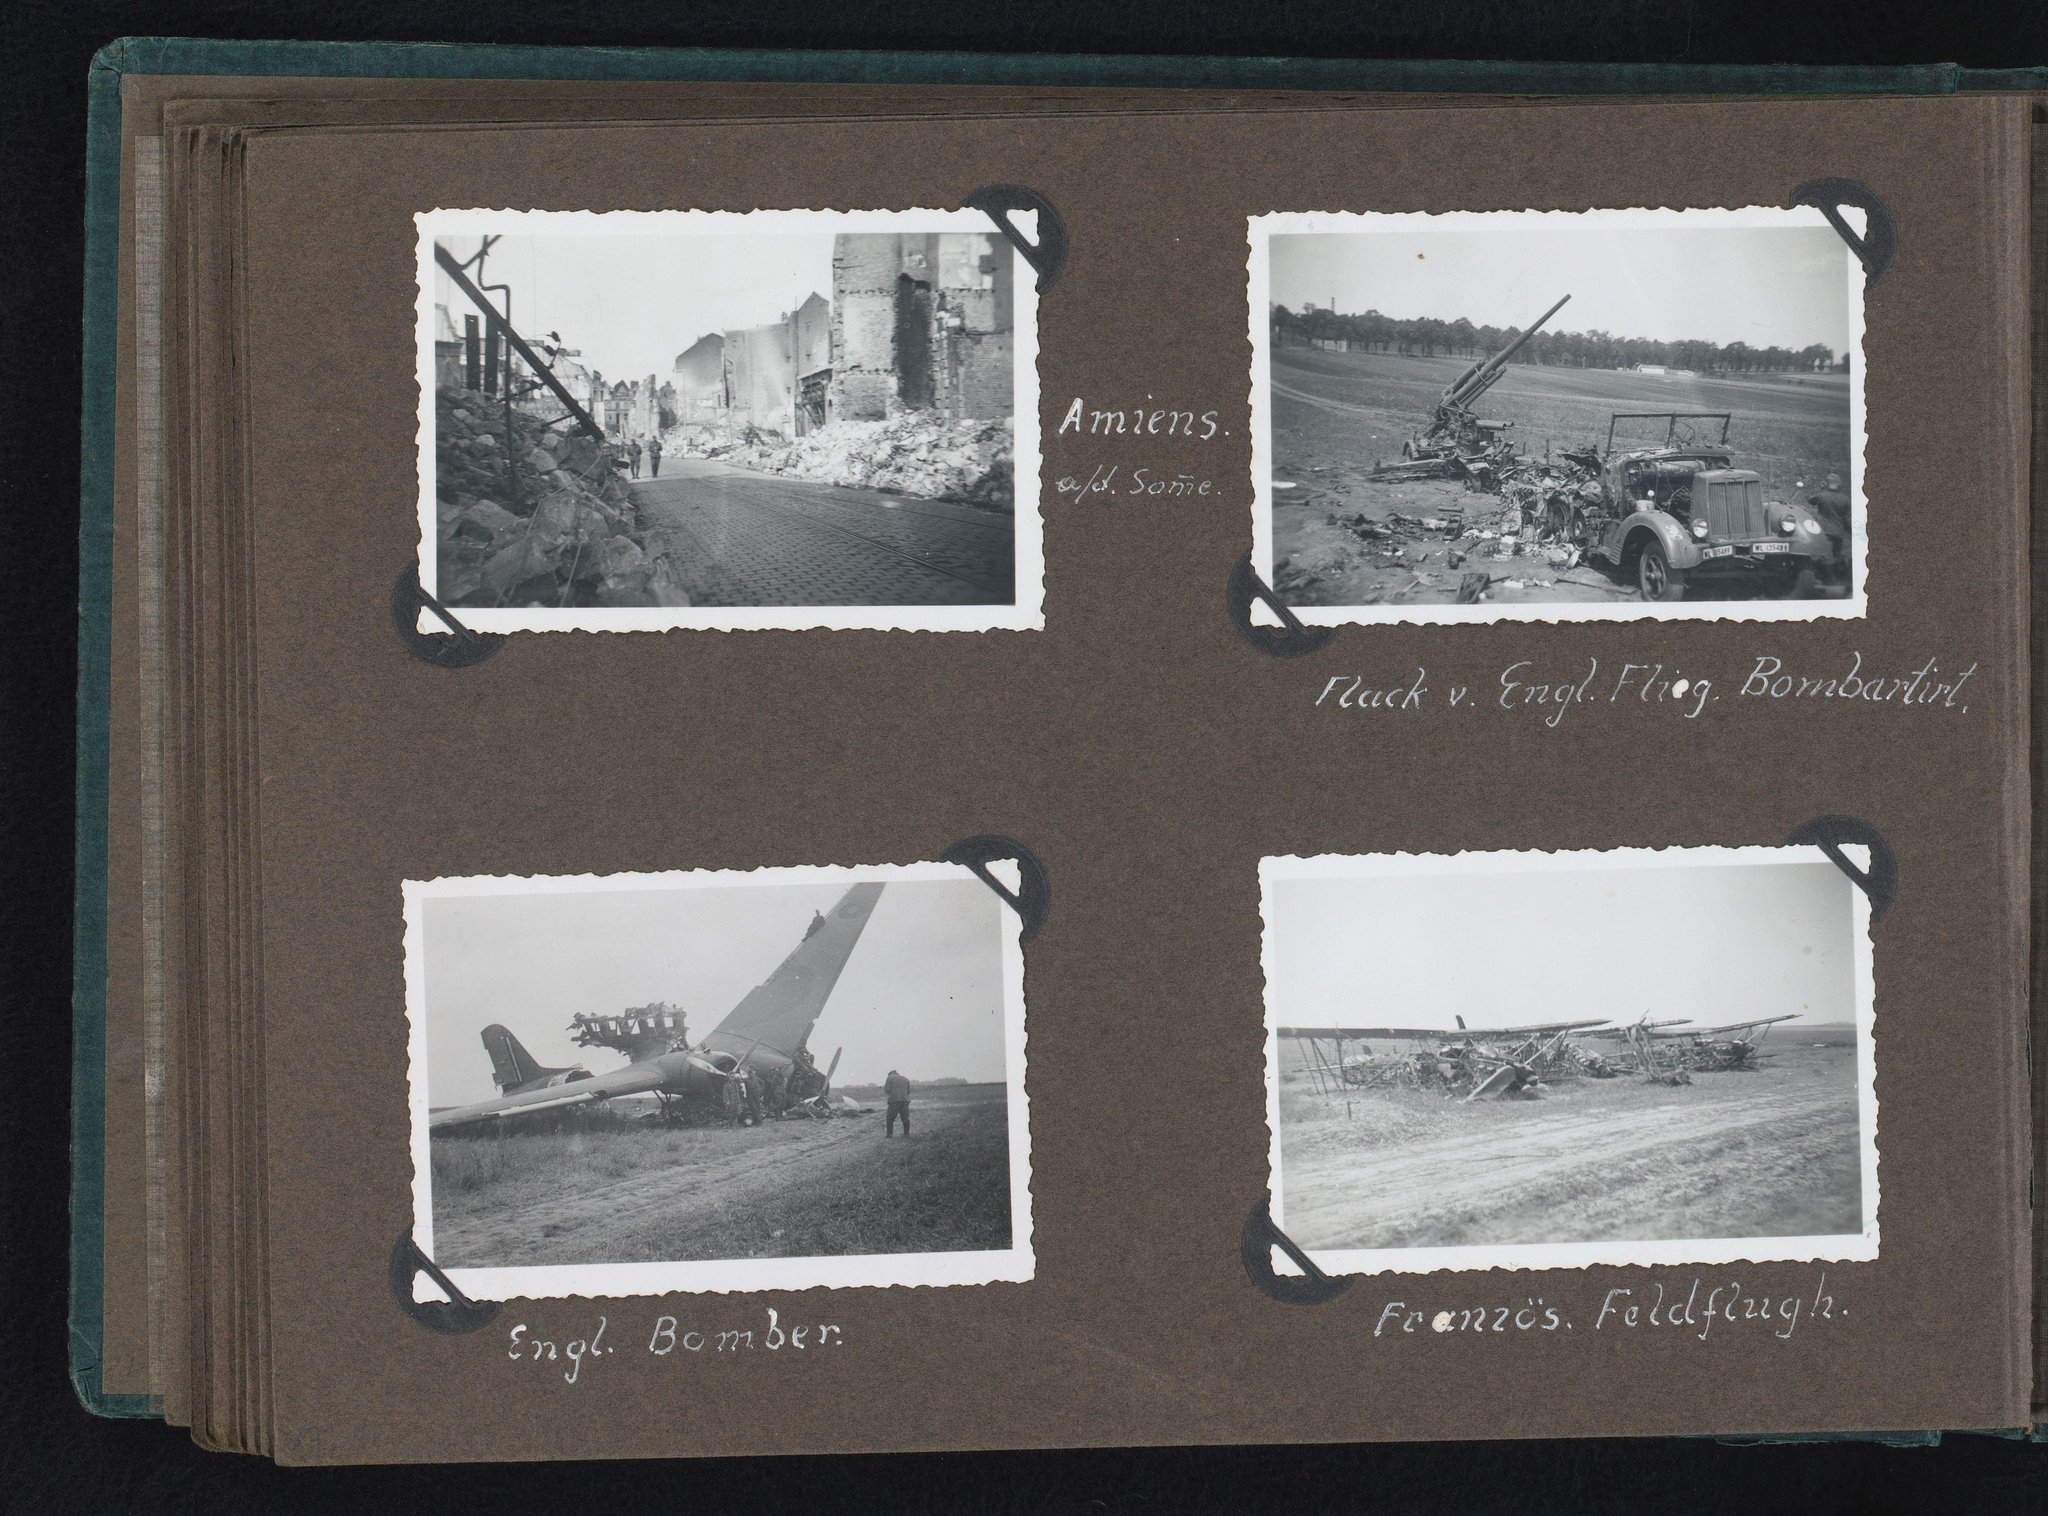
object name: album leaf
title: Ruïnes in Amiens en geallieerde vliegtuigen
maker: Anonymous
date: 1940-1945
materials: cardboard, photographic support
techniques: gelatin silver print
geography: france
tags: aircraft, aeroplane (+ accident, collision, crash ~traffic and transport), firearms: cannon, devastated, ruined place or city (~ warfare), france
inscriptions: inscription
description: Albumblad met vier foto's van oorlogsruïnes in Amiens, neergeschoten Engels vliegtuig, luchtafweergeschut en kapotgeschoten toestellen op een Franse luchthaven. Onderdeel van het fotoalbum 'Kriegserinnerungen' 1940-1945.